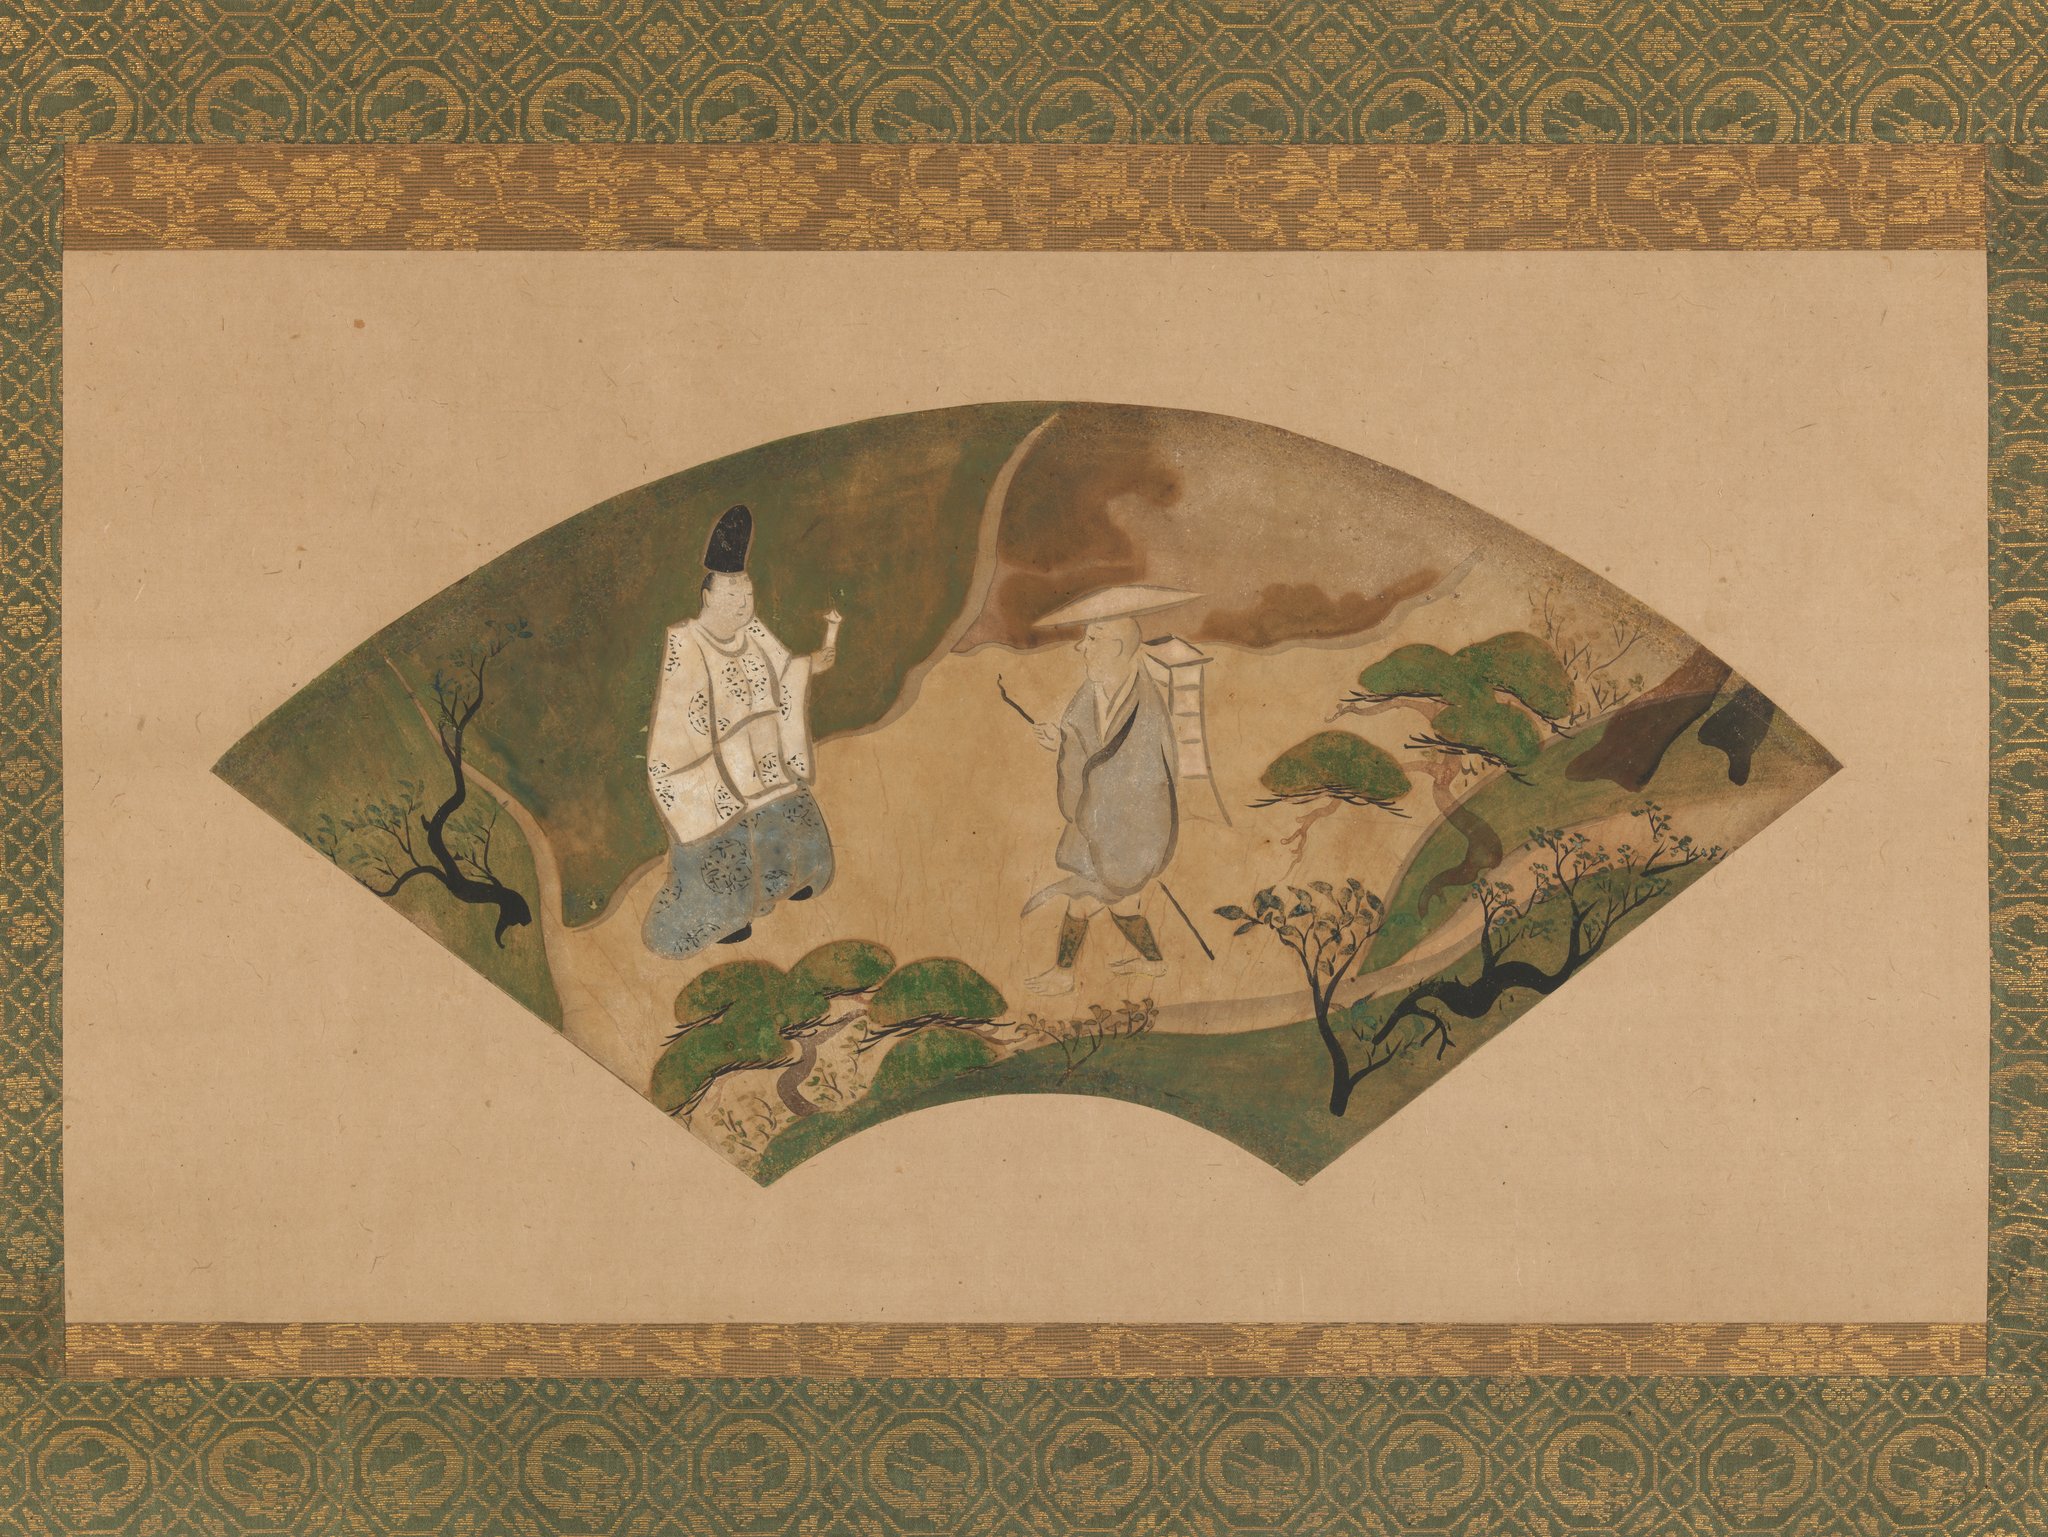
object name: hanging scroll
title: Scene from the Tales of Ise: “Mount Utsu”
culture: japanese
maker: fukae roshū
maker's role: artist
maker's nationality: japanese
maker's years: 1699-1757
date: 1701-1733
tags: men